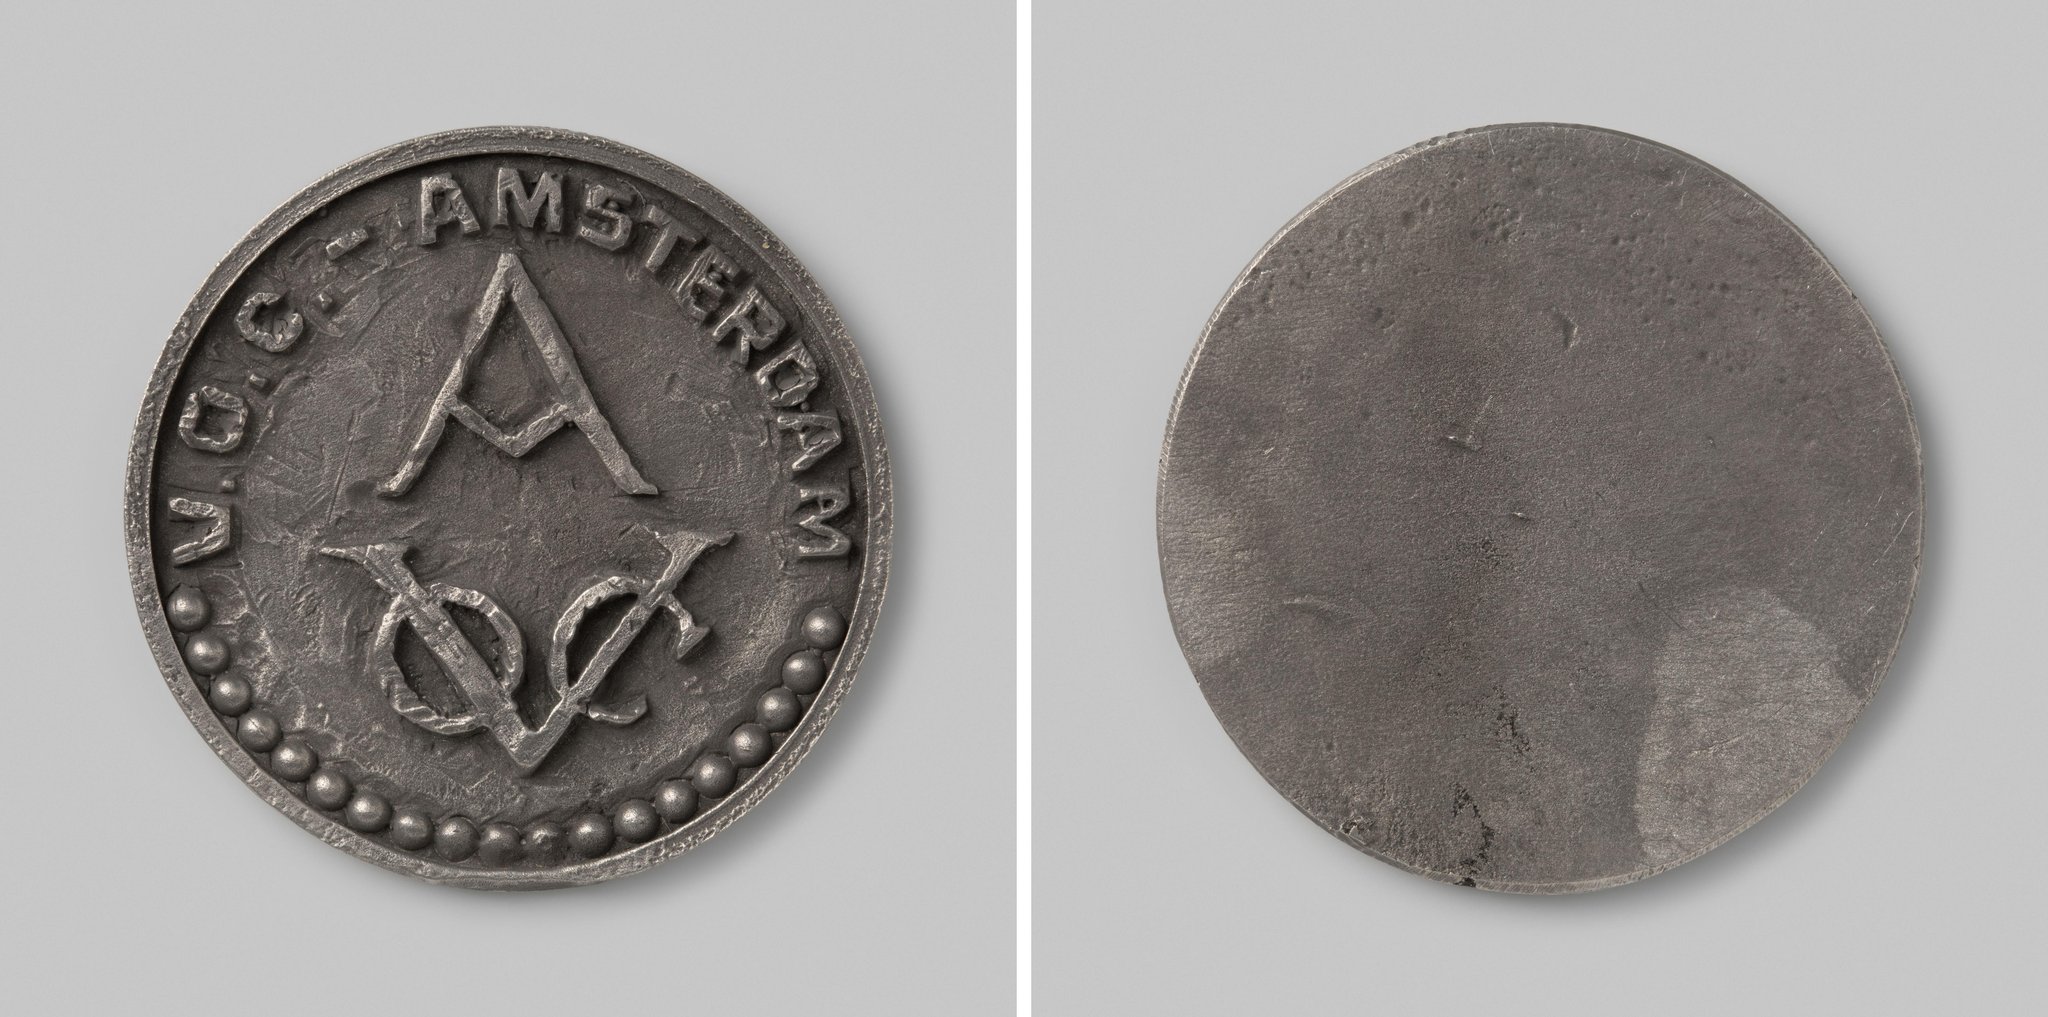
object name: history medal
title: Stichting VOC-schip Amsterdam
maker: Anonymous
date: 1988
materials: tin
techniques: casting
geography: tiel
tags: amsterdam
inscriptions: inscription: ‘V O C AMSTERDAM / A VOC’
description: Eenzijdige tinnen penning. Voorzijde: VOC monogram van kamer Amsterdam binnen omschrift en parelrand. Keerzijde: blanco.